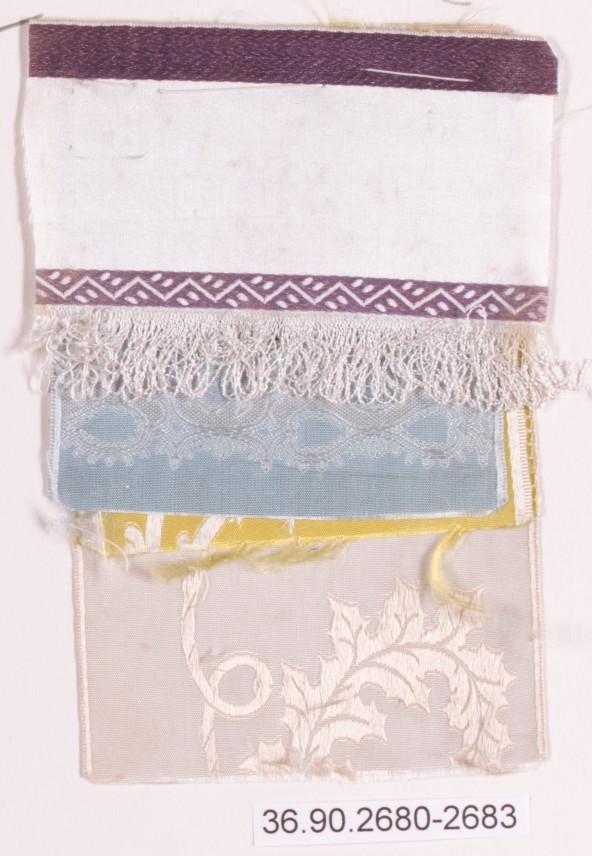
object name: ribbon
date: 1801-1900